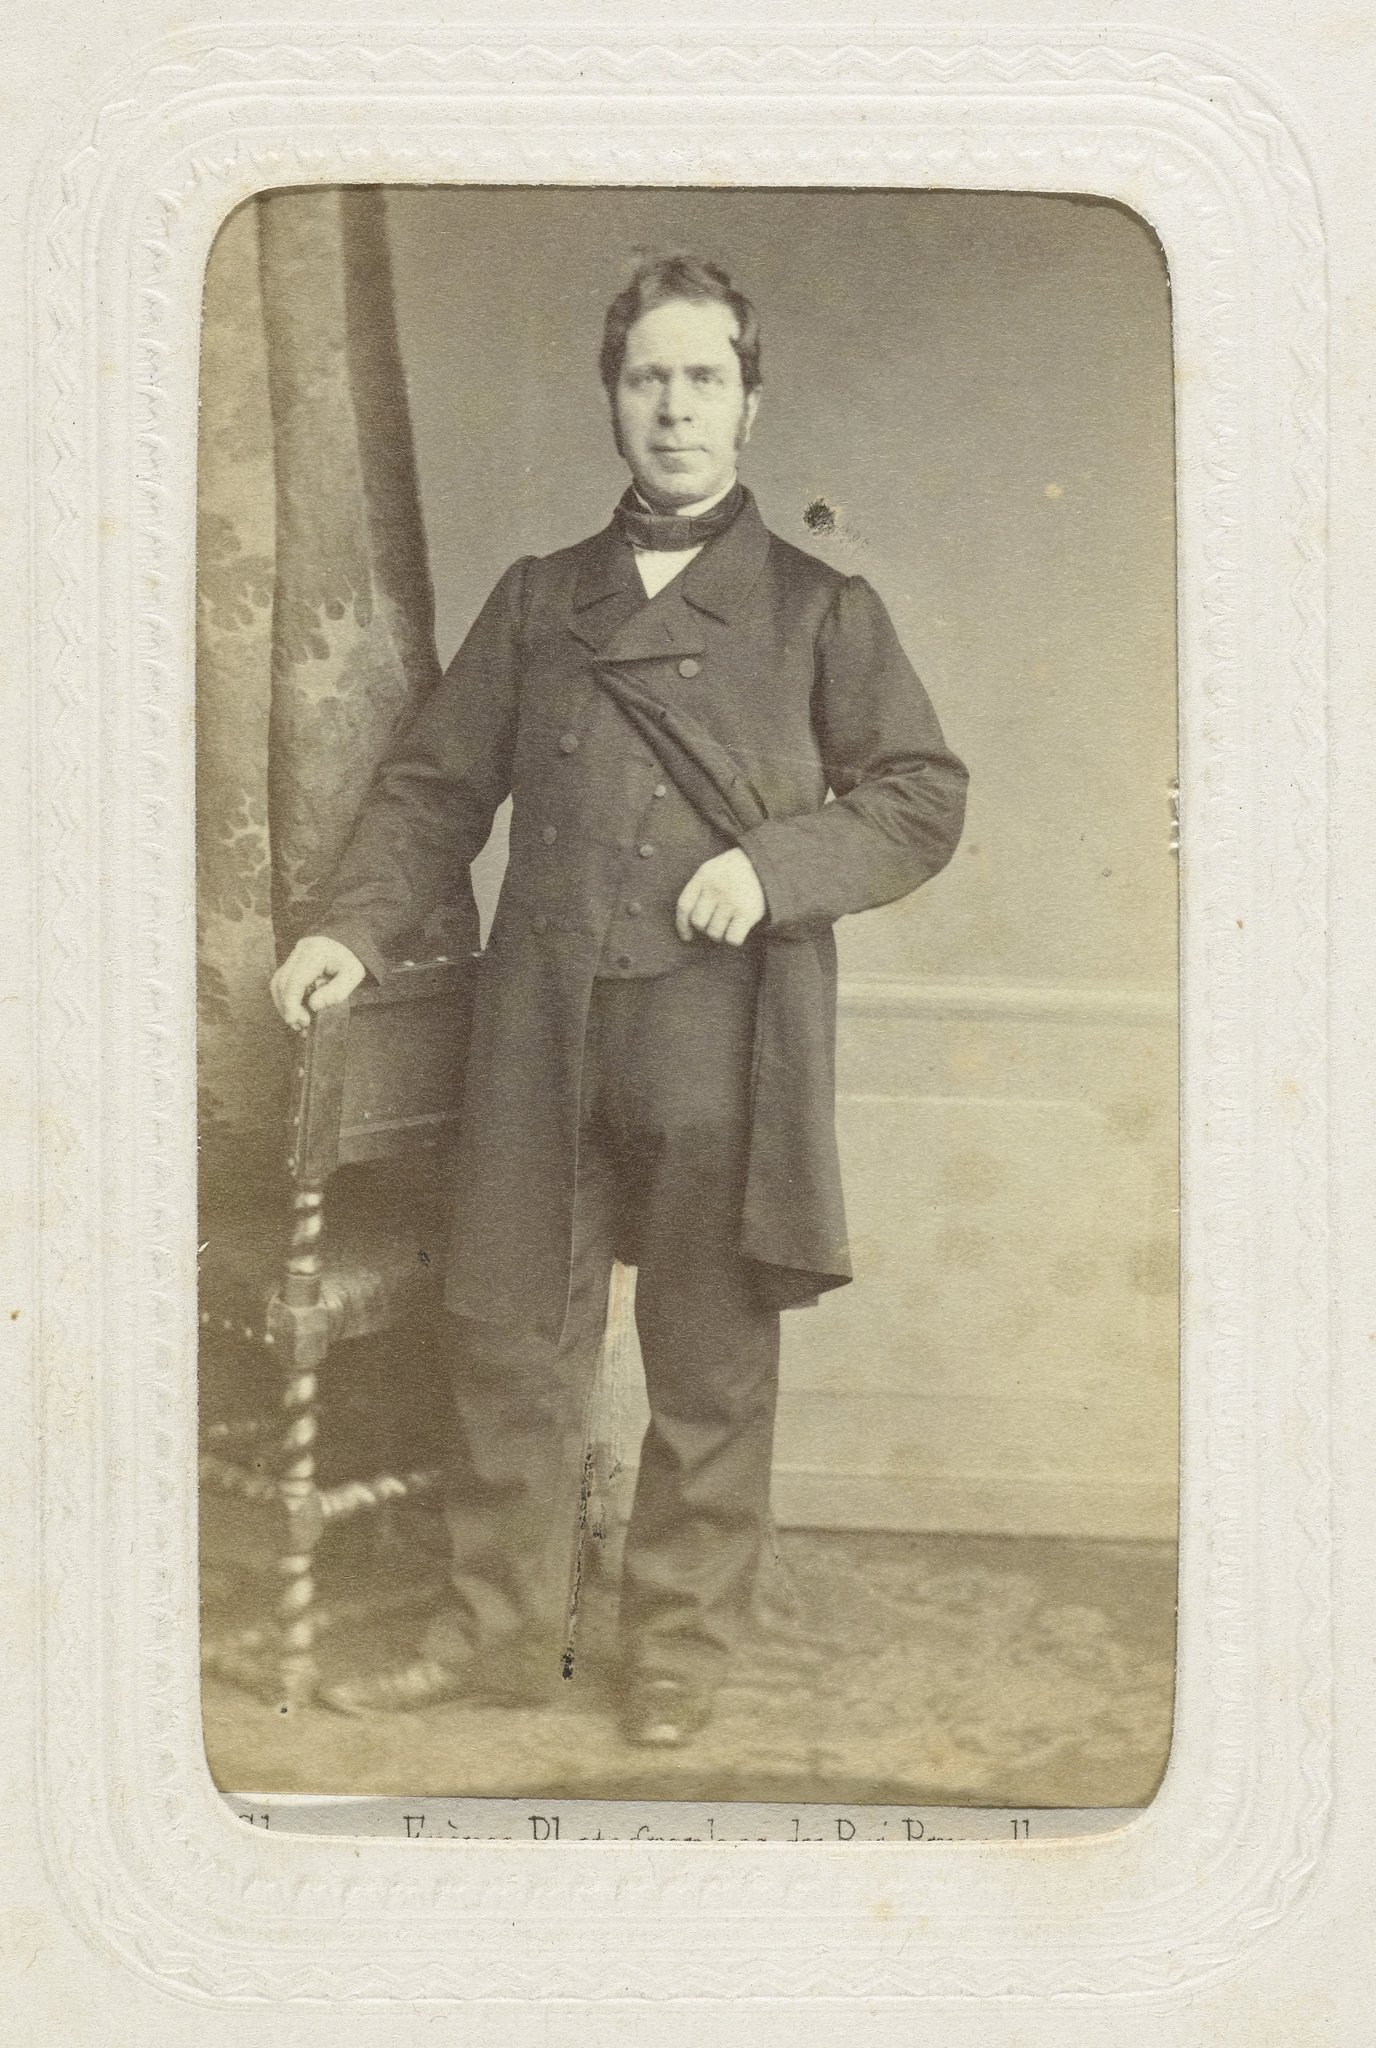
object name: carte de visite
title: Studioportret van een man in lange jas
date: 1863-1870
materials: cardboard, paper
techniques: albumen print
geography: brussels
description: De man leunt met ene hand op een rugleuning van een stoel